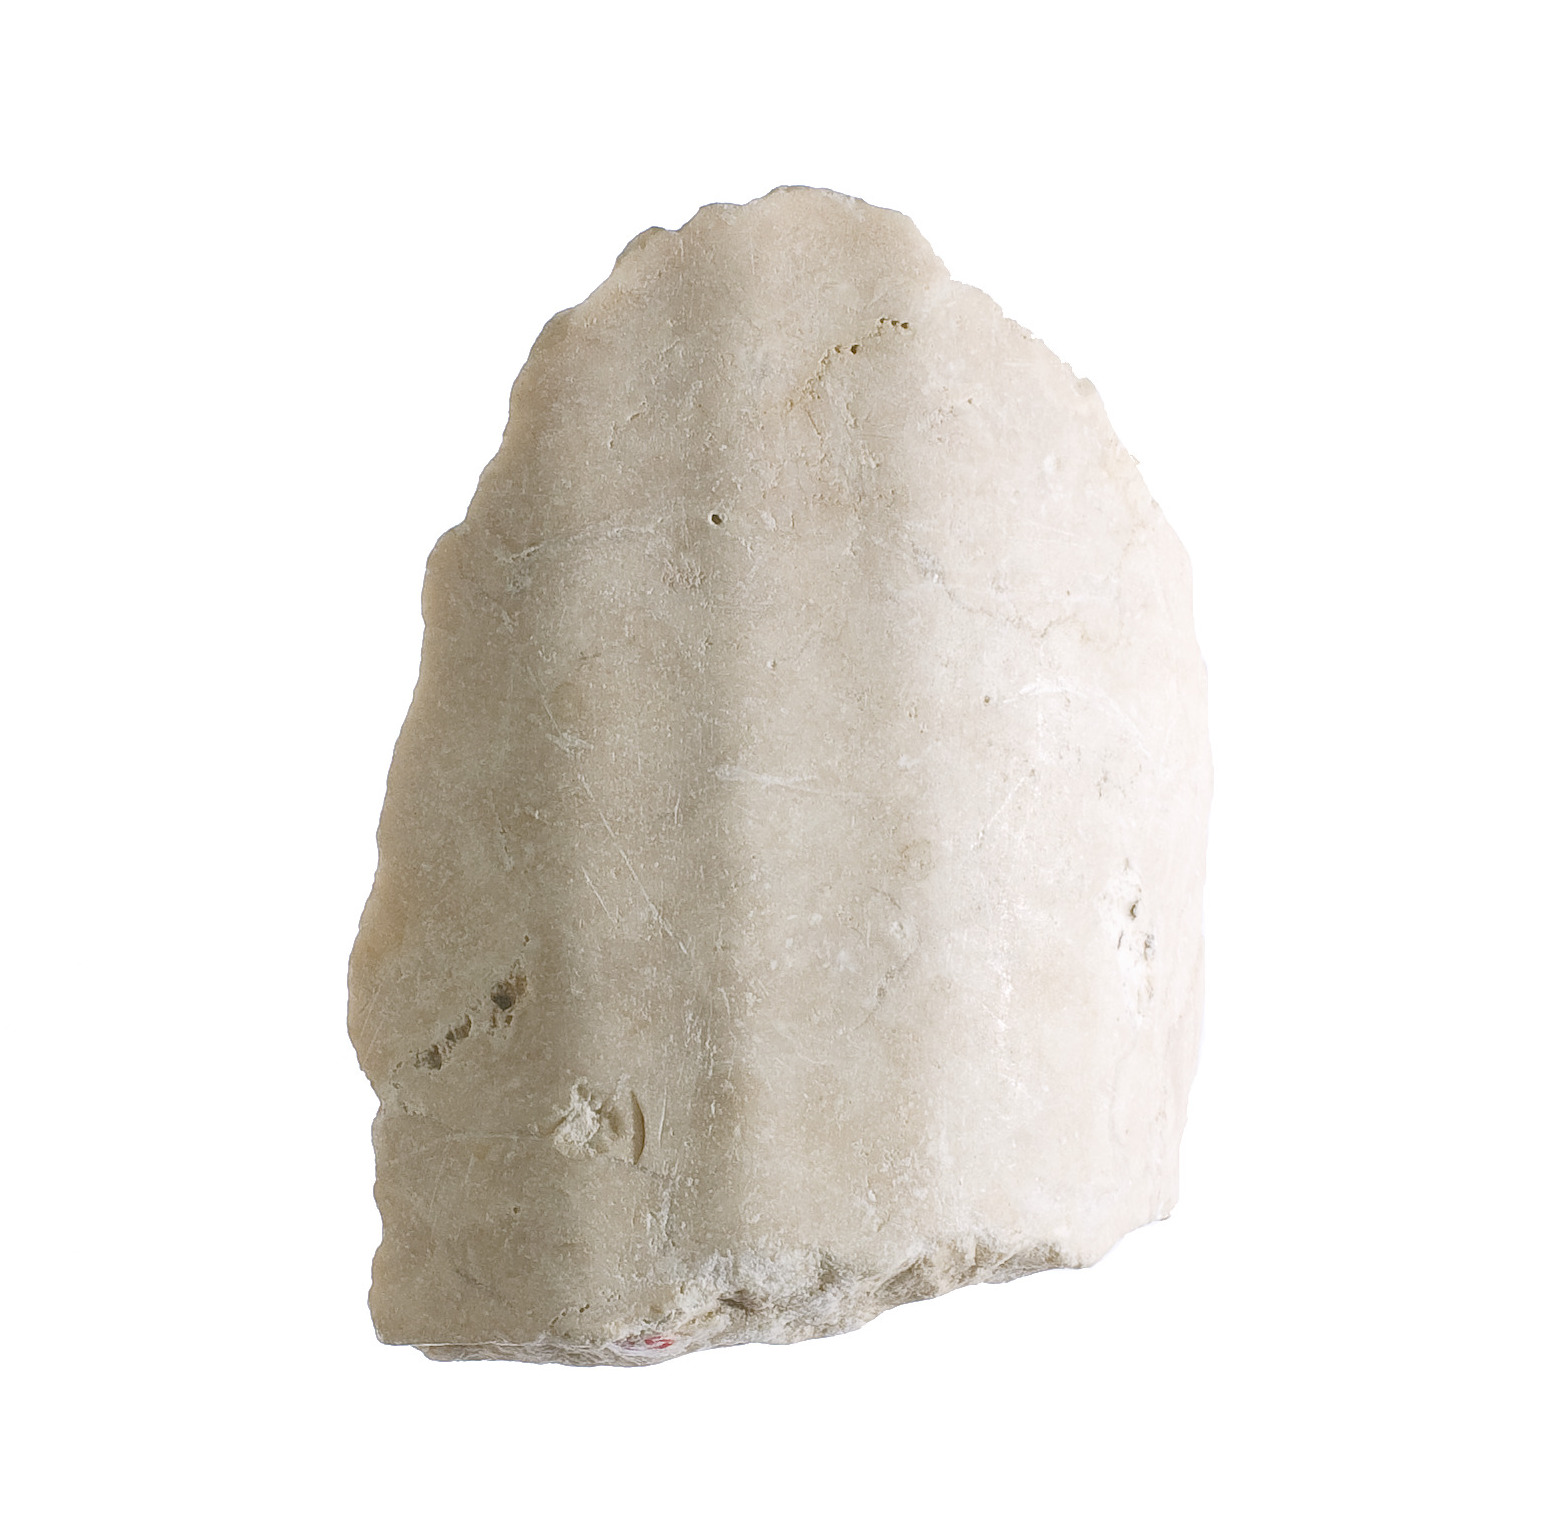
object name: limb with garment, pleating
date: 1353-1336 BCE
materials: limestone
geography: egypt